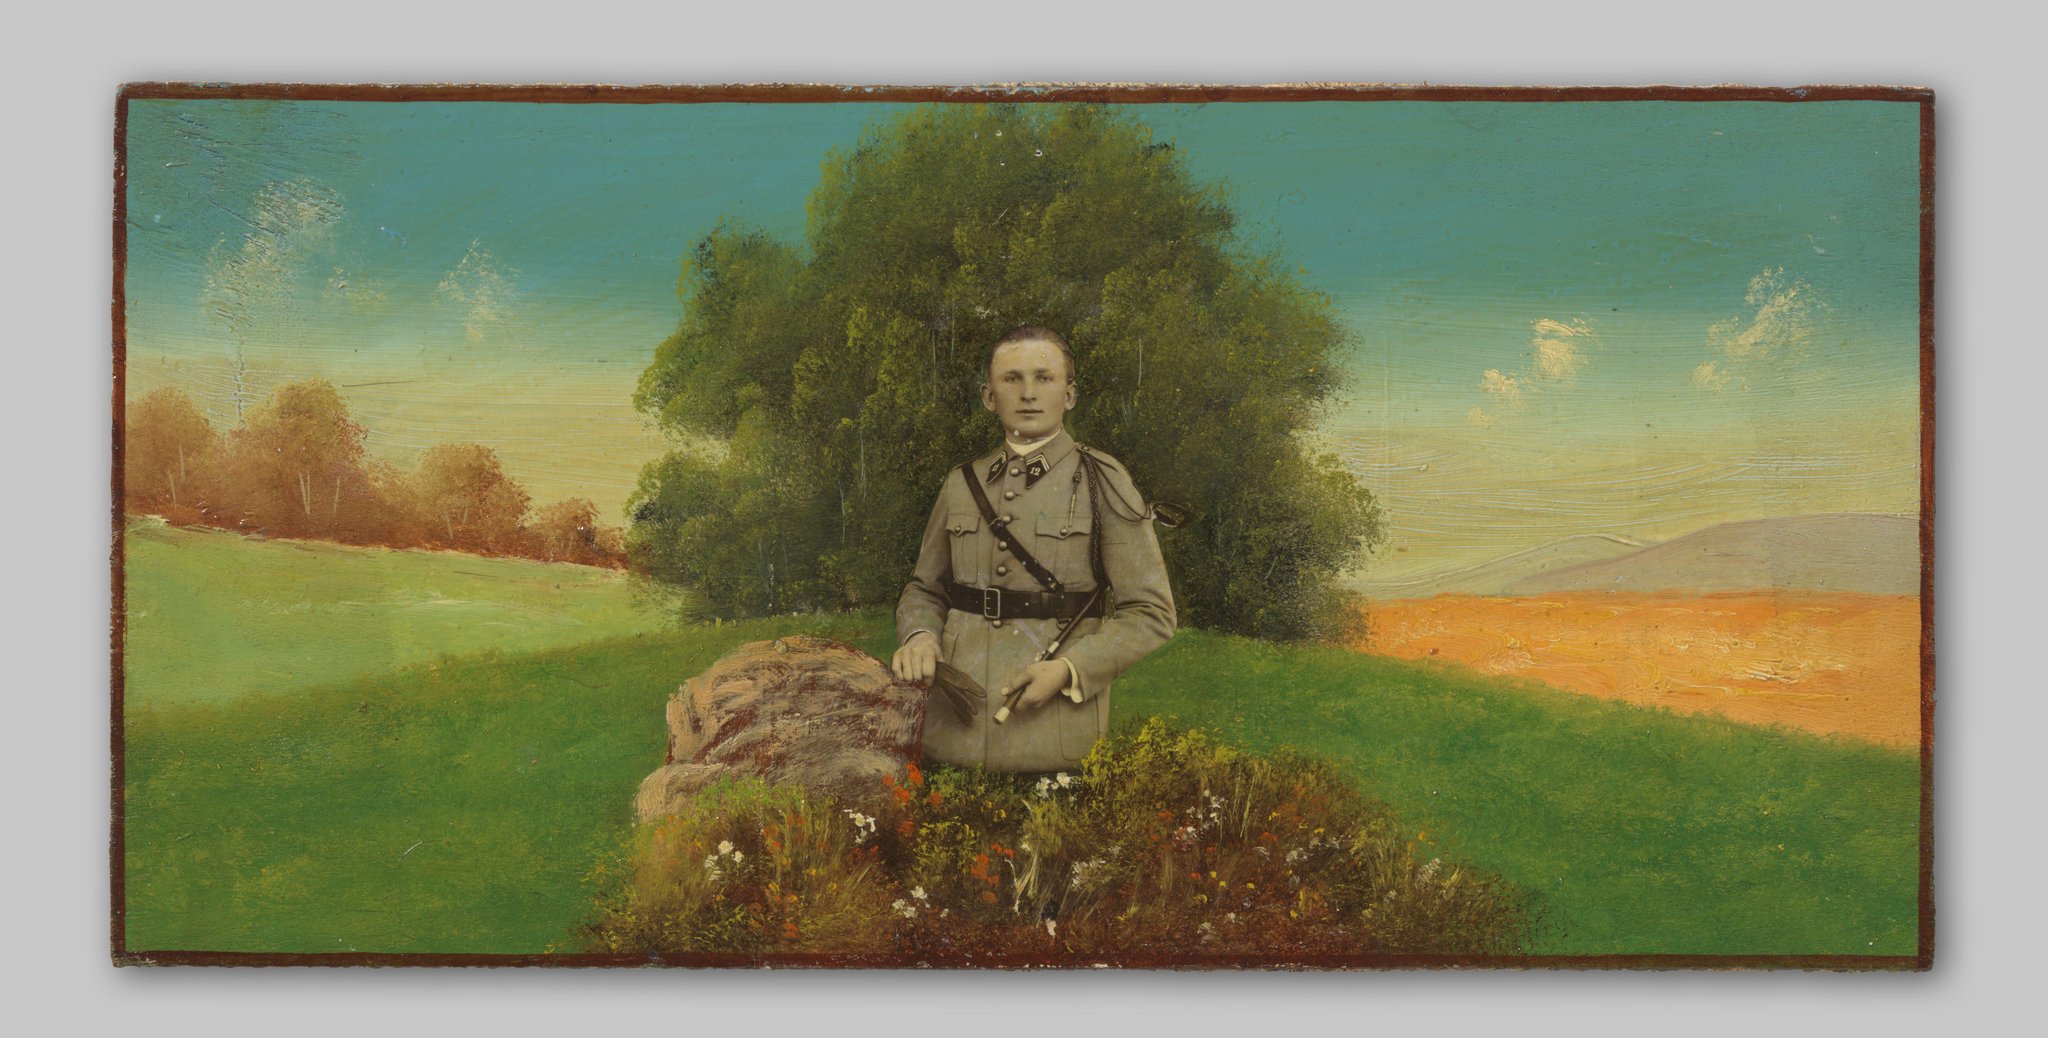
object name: photograph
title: Portret van een onbekende militair in een geschilderd landschap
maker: Anonymous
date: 1910-1950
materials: metal, paint, paper, wood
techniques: albumen print, brush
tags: anonymous historical person portrayed, the soldier; the soldier's life, landscapes - hh - ideal landscapes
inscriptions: inscription: ‘Macheboeuf/ 108 Rue de Varves 108/ F.q./ d.e.d./ Paris 14a’, number: ‘W. 447/ 4790’